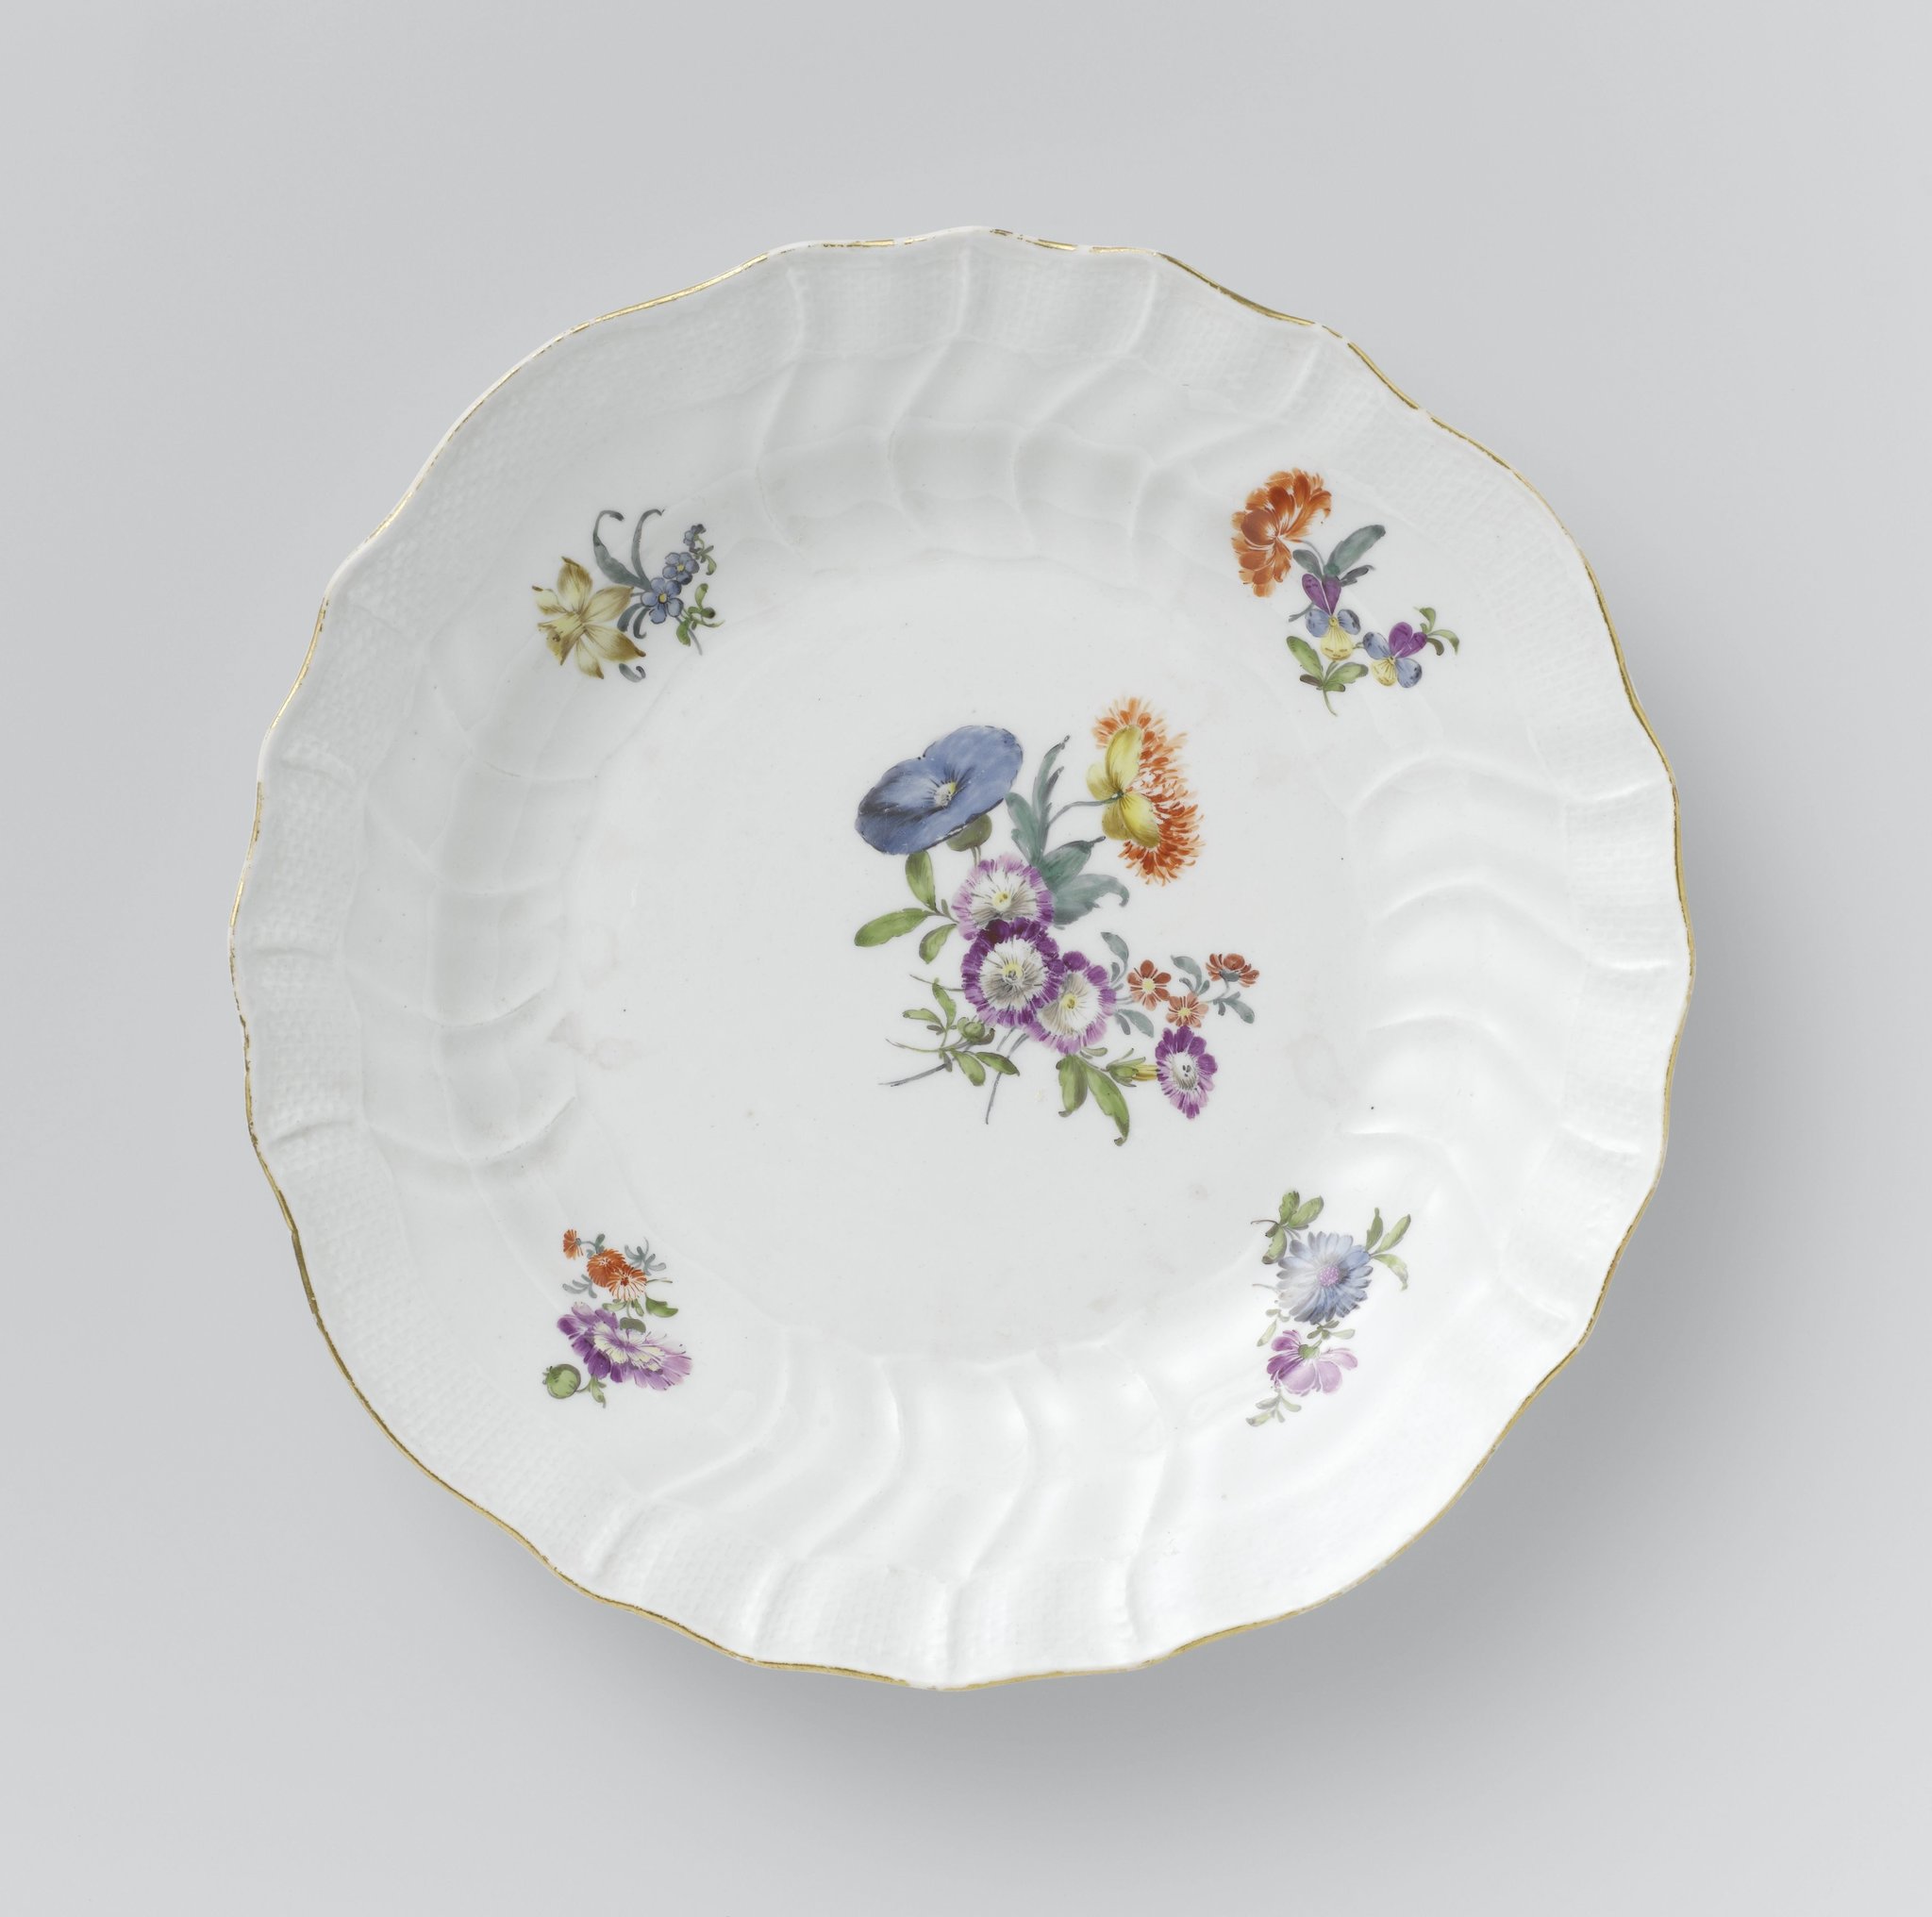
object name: plate dish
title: Bord, veelkleurig beschilderd met Deutsche Blumen, insekten en vruchten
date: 1750-1760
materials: porcelain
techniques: painted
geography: meissen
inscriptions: factory mark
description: Rond bord van beschilderd porselein. De rand is versierd met het Neuozier-patroon. De beschildering bestaat uit Deutsche Blumen, insekten en vruchten. Het bord is gemerkt en hoort bij een servies (BK-17474-1 t/m BK-17474-253).